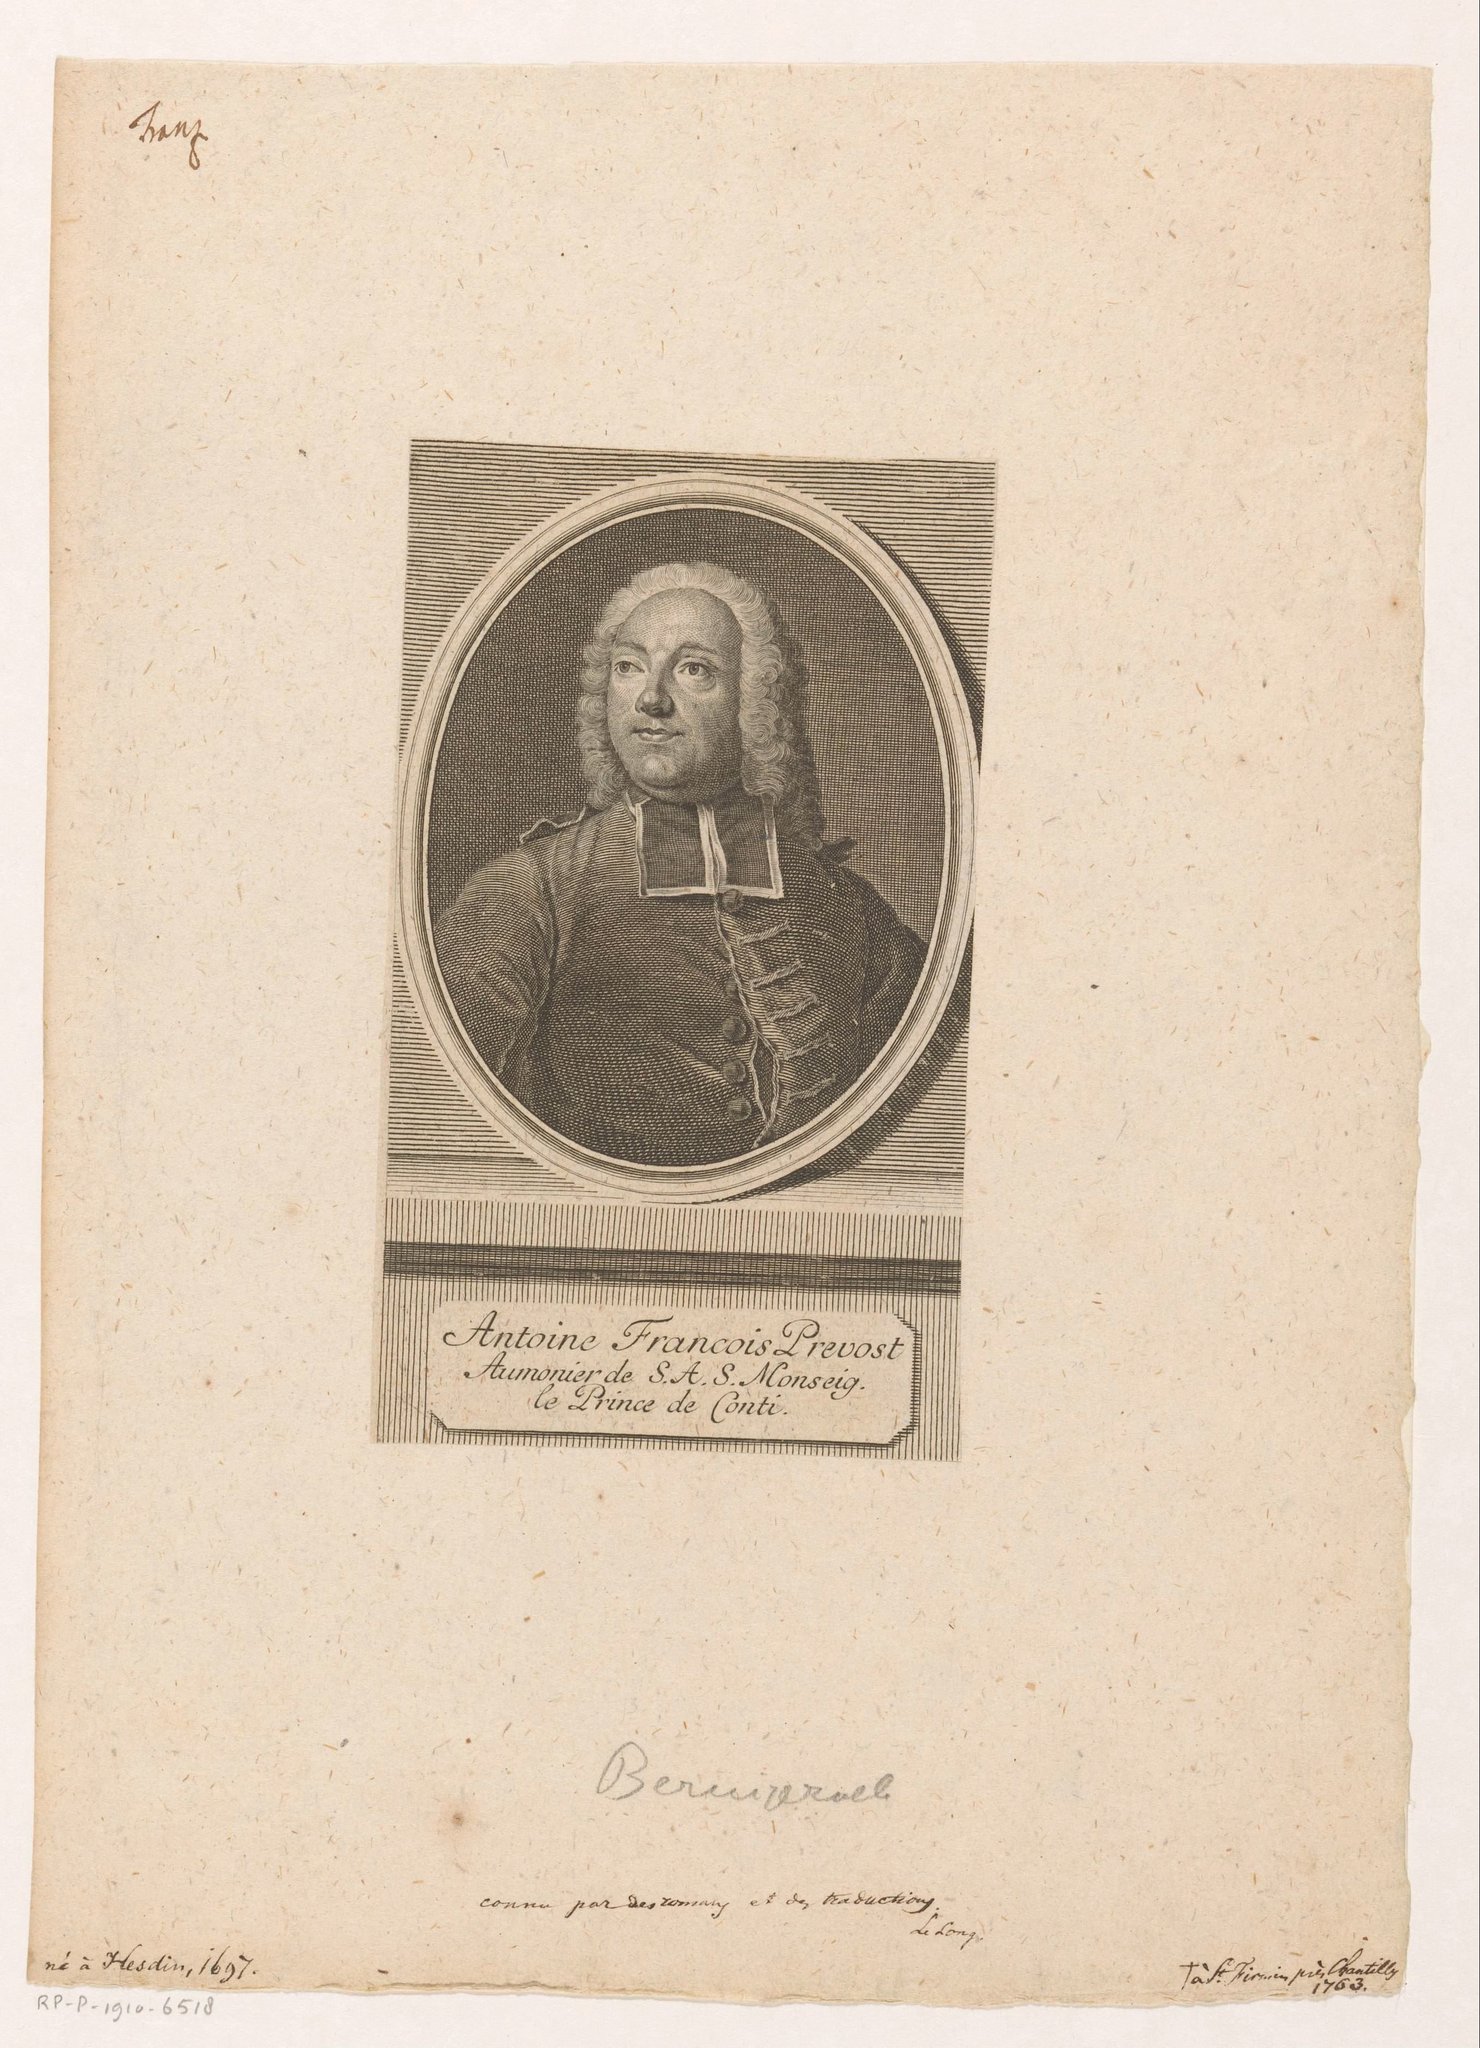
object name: print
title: Portret van Antoine François Prevost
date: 1736-1767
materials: paper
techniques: engraving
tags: historical persons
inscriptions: collector's mark: Lugt 2228